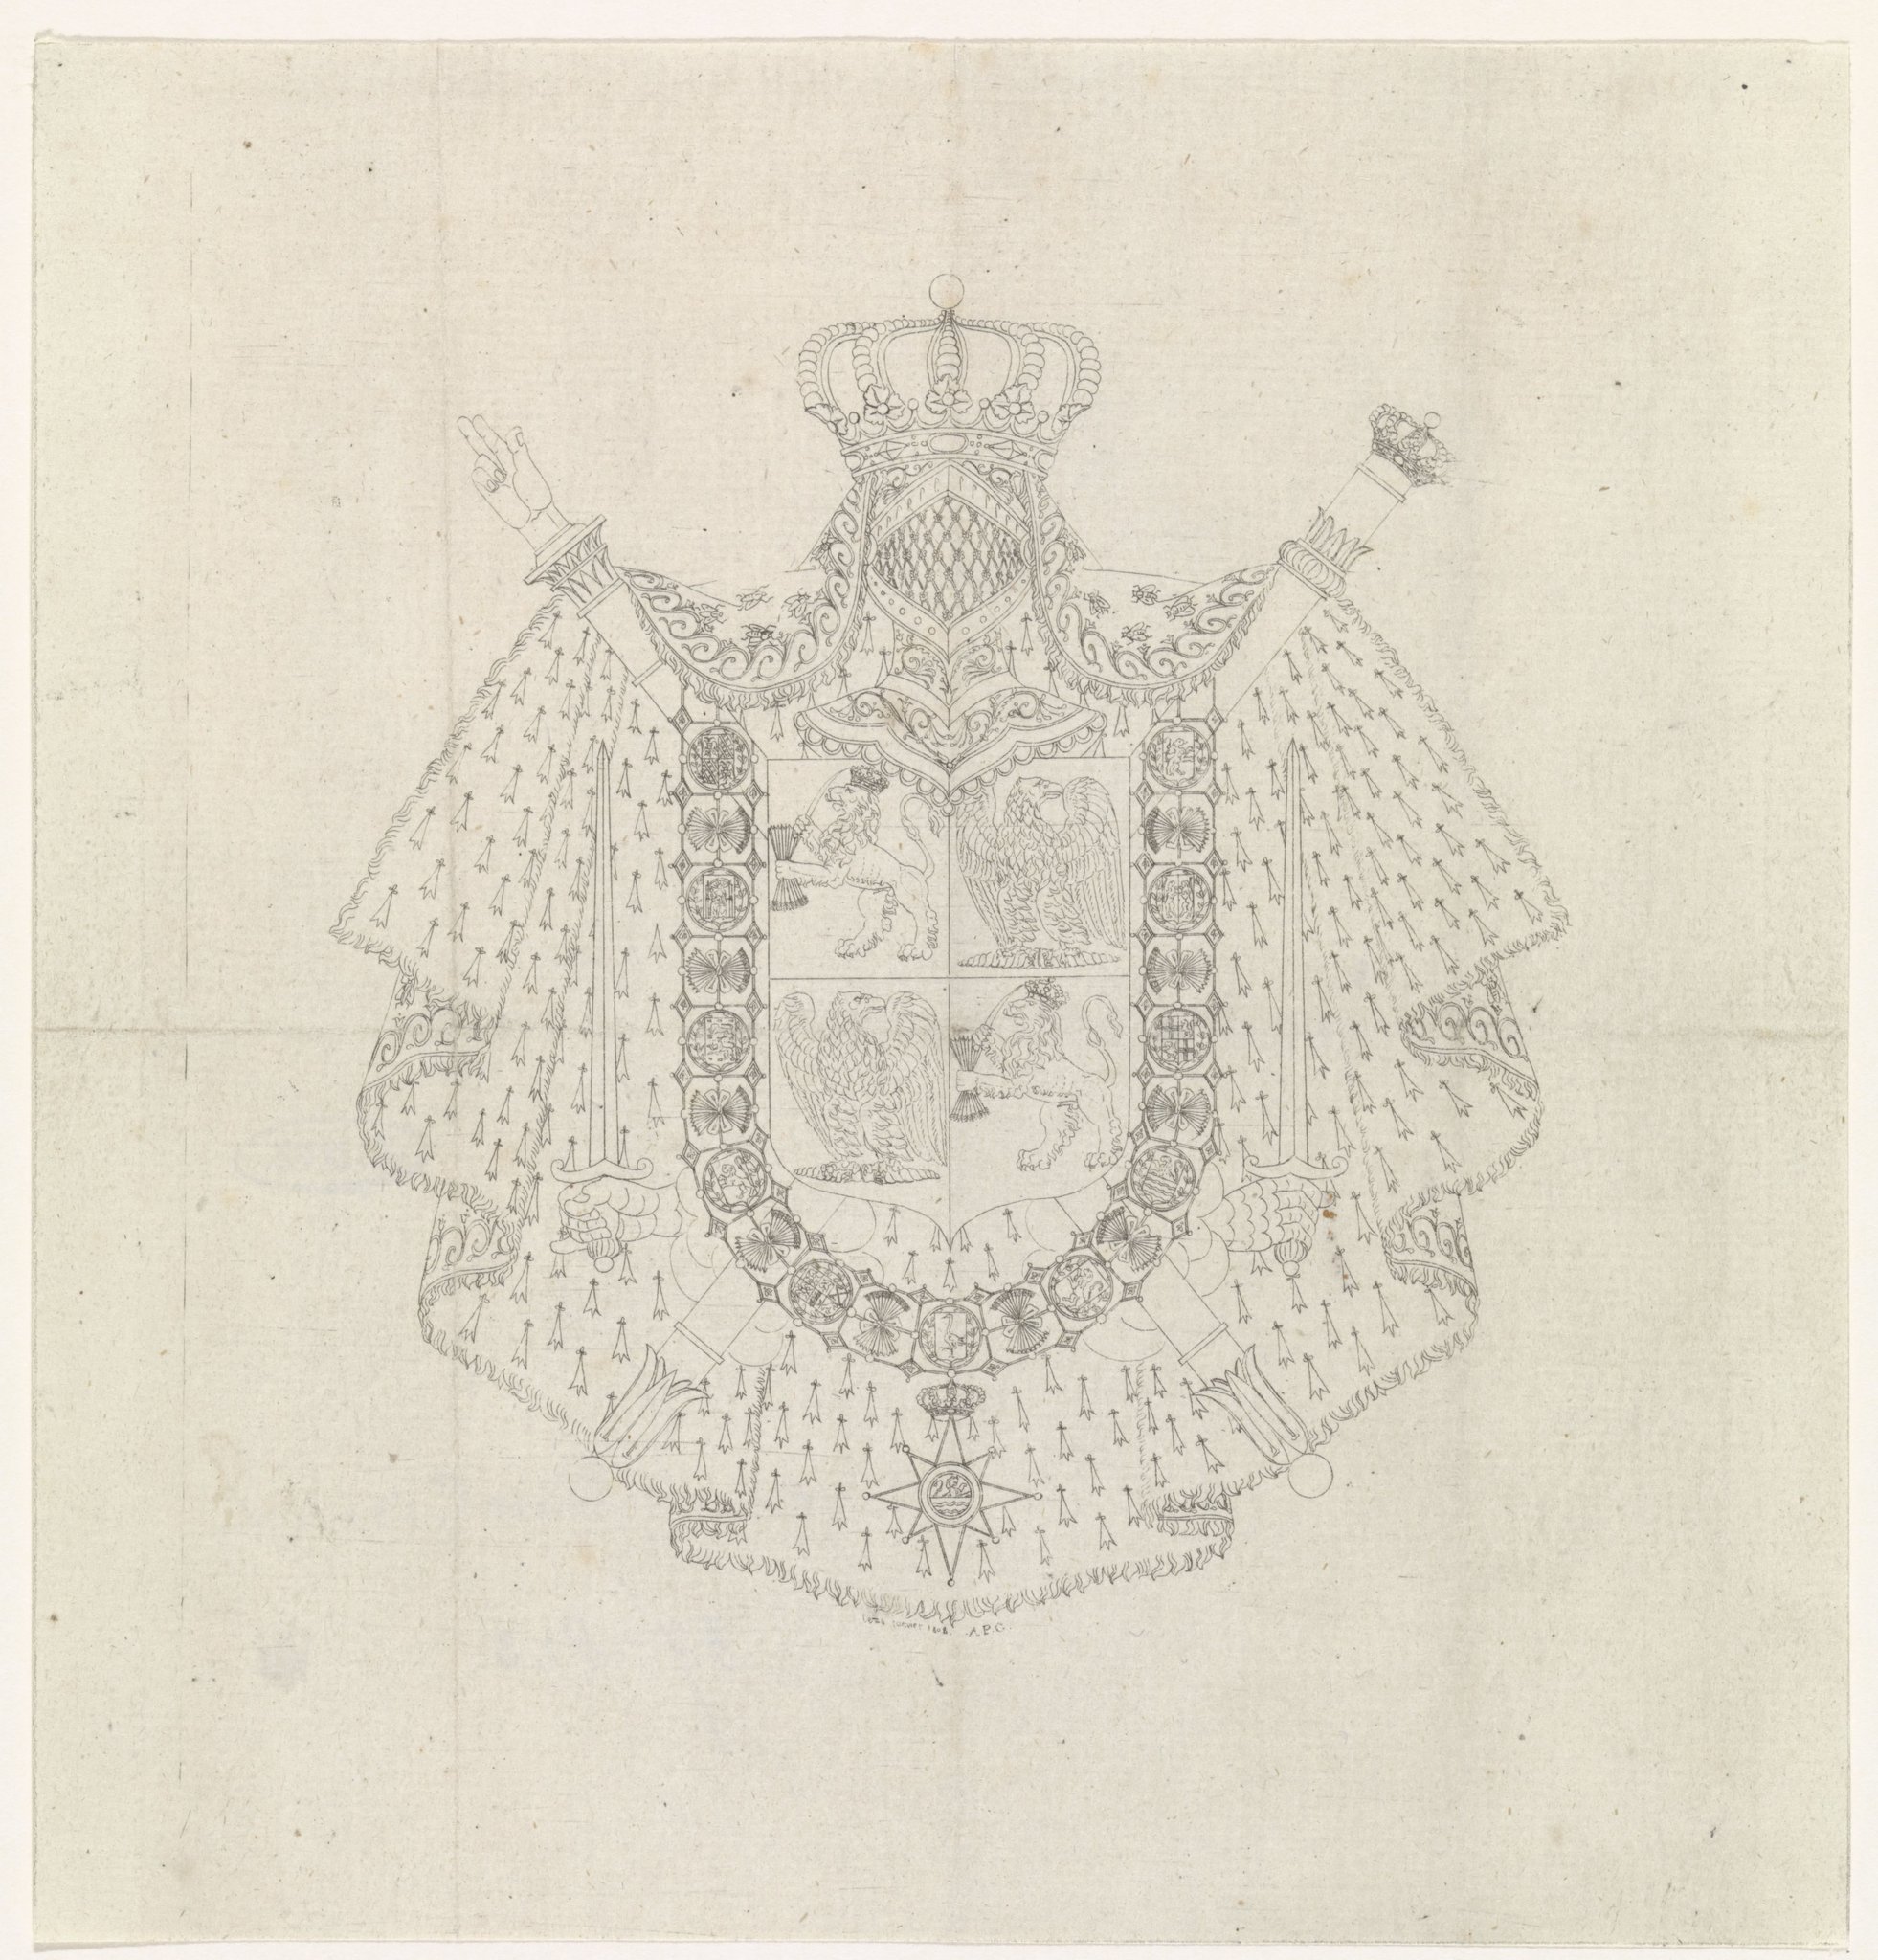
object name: print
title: Ontwerp van het wapen van Lodewijk Napoleon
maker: alphonse pierre giraud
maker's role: print maker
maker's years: 1786-1863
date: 1808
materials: paper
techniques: etching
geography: amsterdam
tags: louis napoleon (king of holland), armorial bearing, heraldry - aa - female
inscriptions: collector's mark: Lugt 2760, collector's mark: Lugt 2228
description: Ontwerp van het wapen van Lodewijk Napoleon als heerser over het koninkrijk Holland. Op het schild een helm, gekroond met een kroon. Om de helm een koningsmantel. Achter het schild twee scepters, eindigend in een kroon (rechts) en een platte hand (links). Het wapen combineert de gouden adelaar van het Franse Keizerrijk en de Bataafse leeuw.